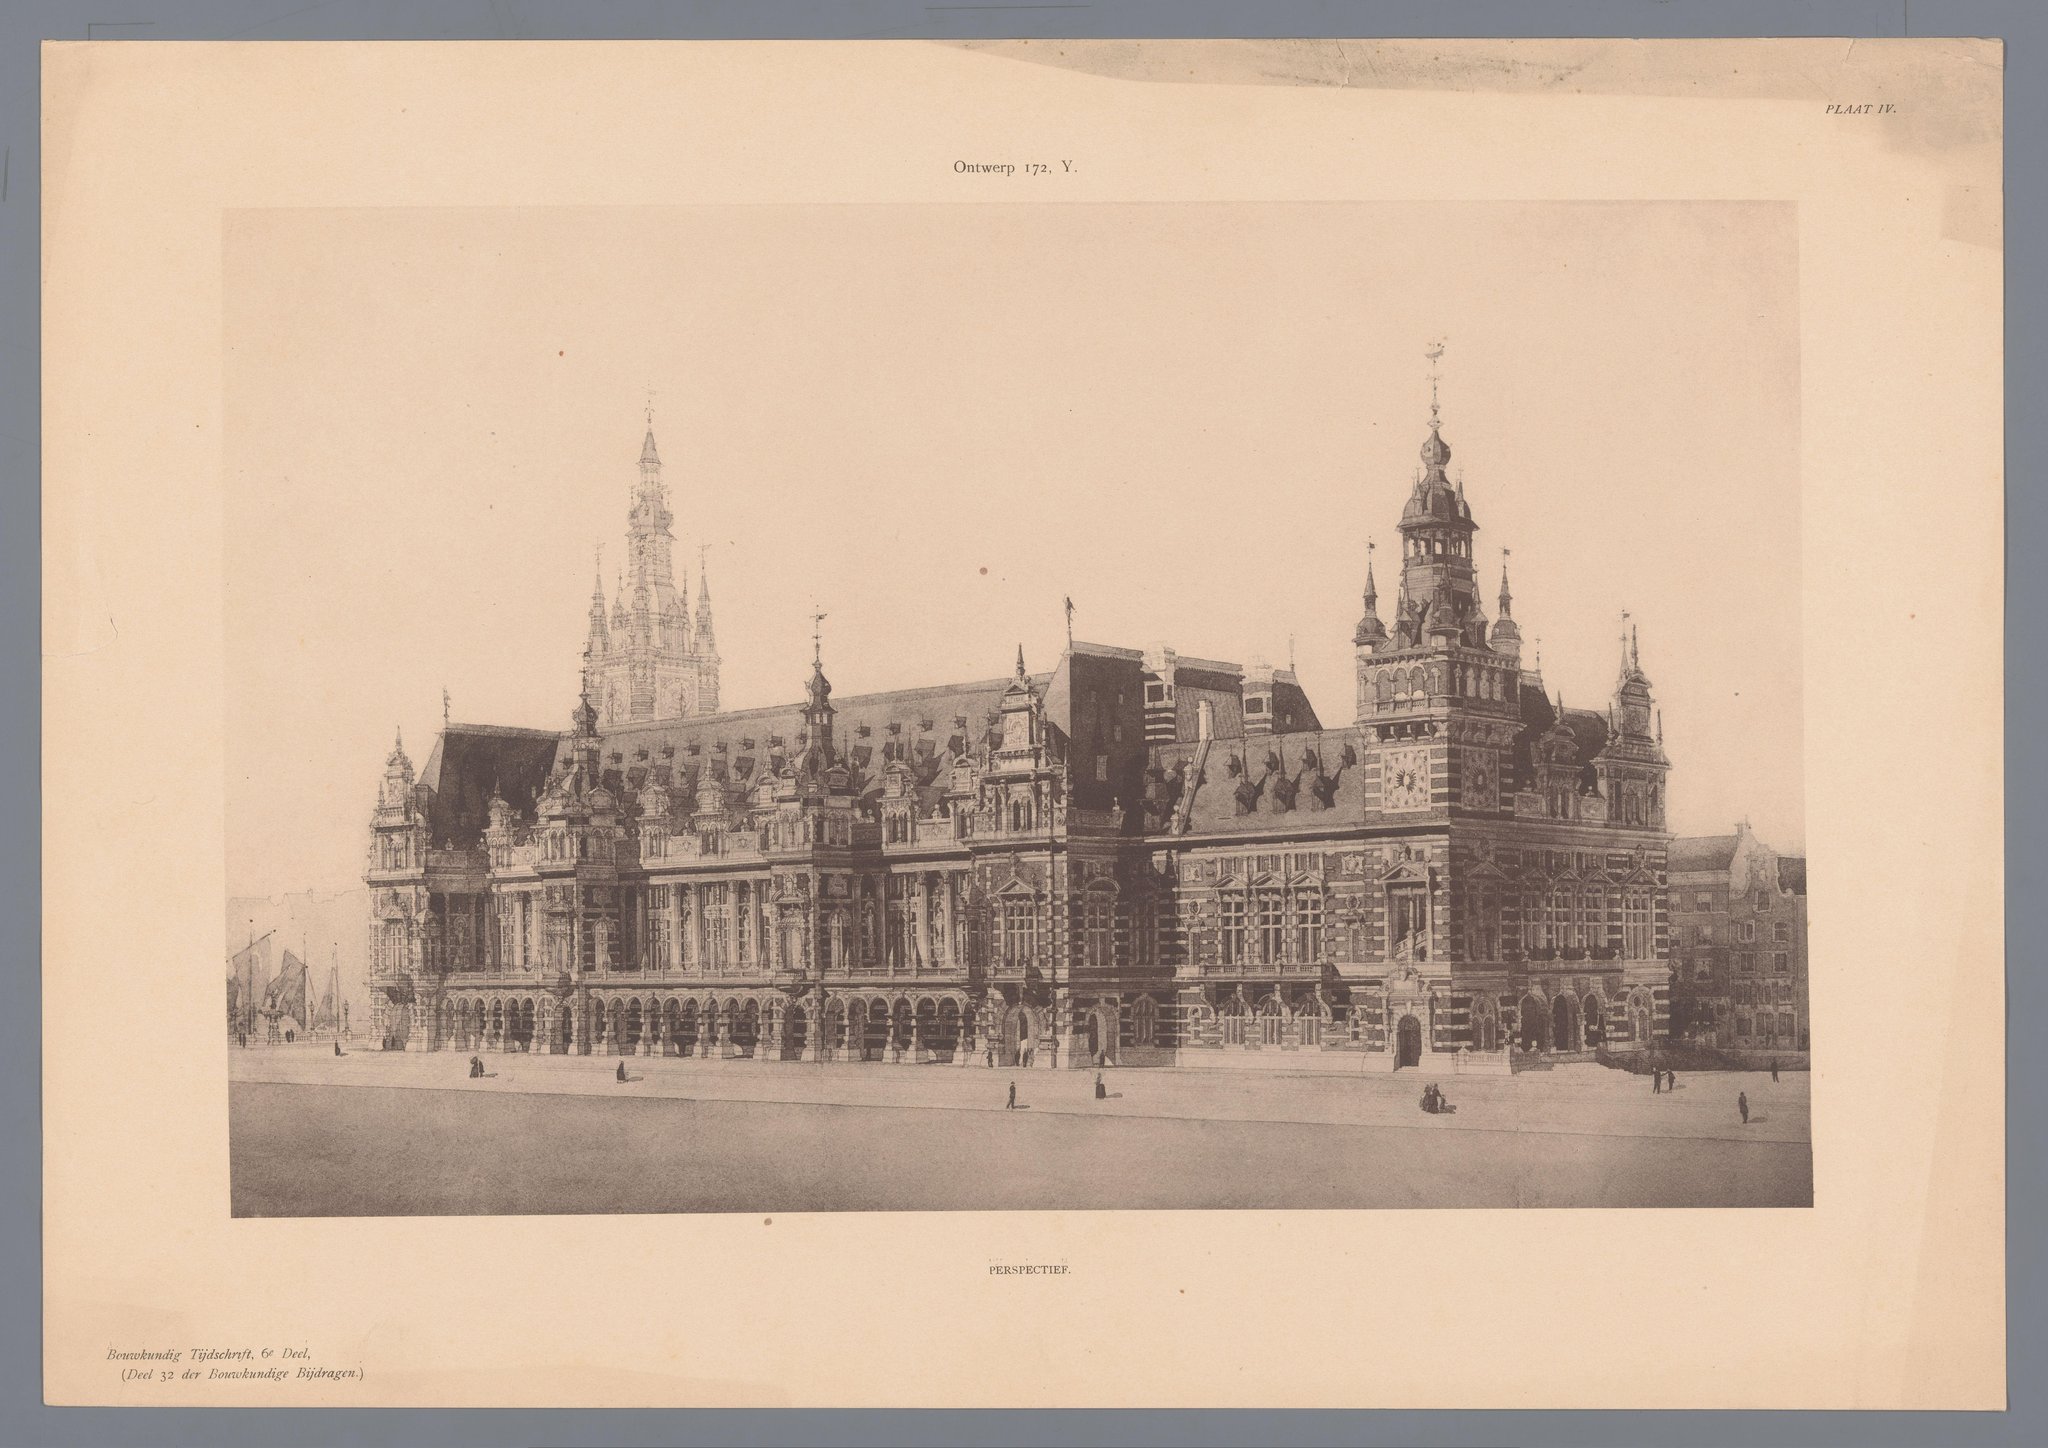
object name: book illustration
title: Ontwerp voor een nieuw beursgebouw in Amsterdam: perspectieftekening van ontwerp 172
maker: Anonymous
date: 1886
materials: paper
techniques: photograph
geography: amsterdam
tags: market-hall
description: Prent uit: Bouwkundig tijdschrift 6, deel 32 der bouwkundige bijdragen (1886), pl. 4.